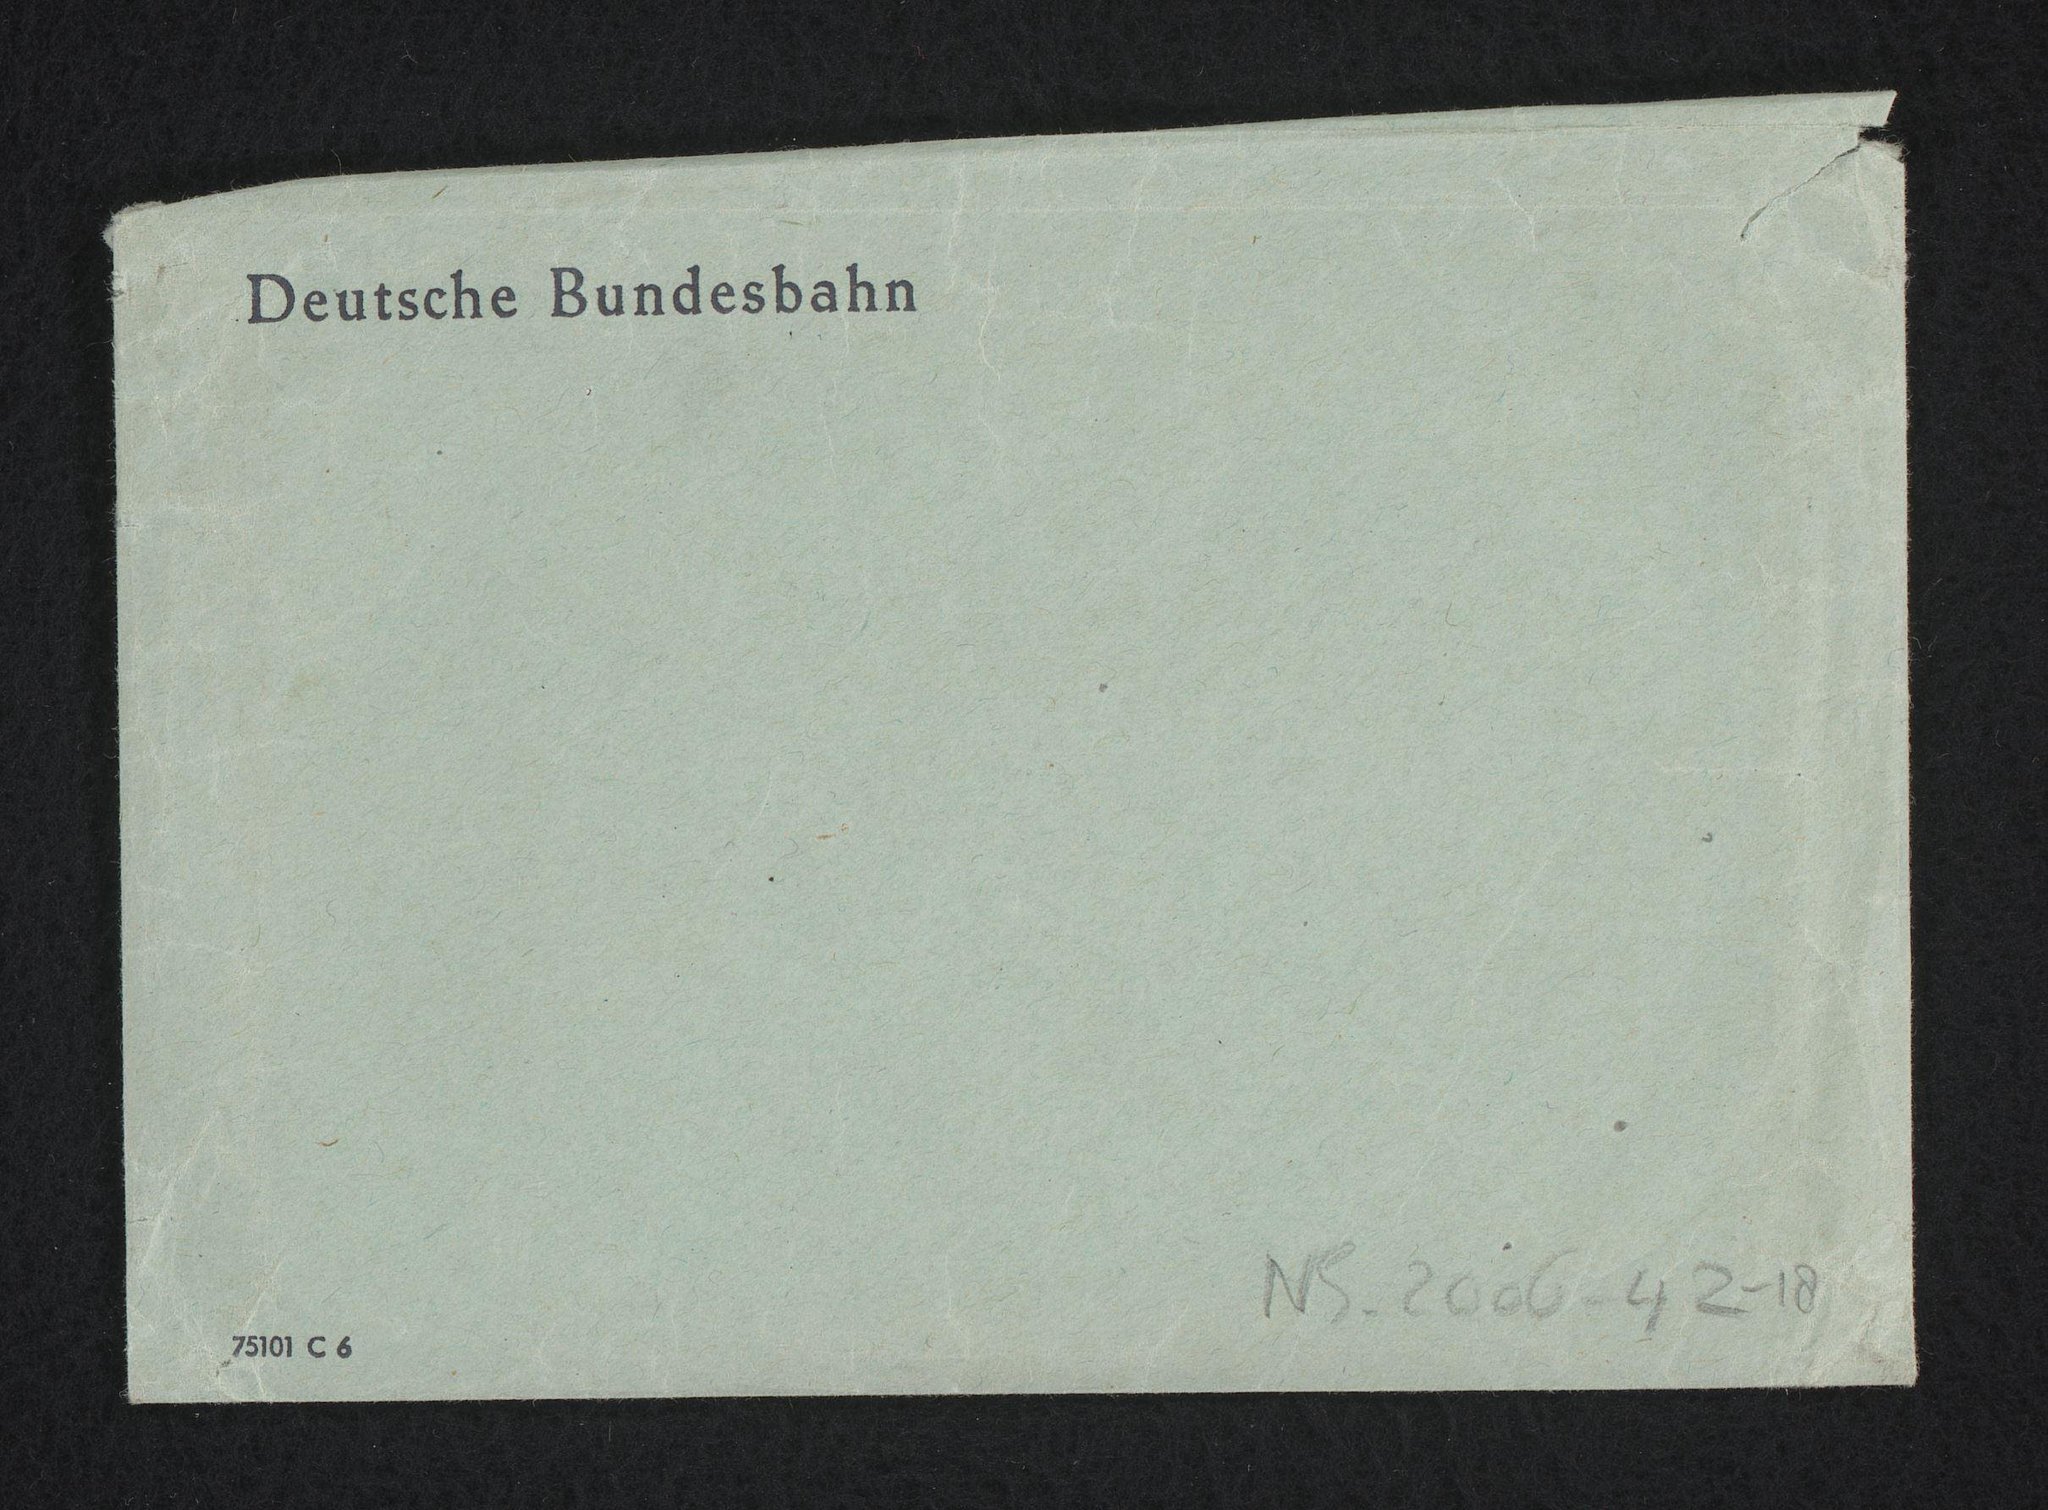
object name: folder container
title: Envelop met losse foto's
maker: Anonymous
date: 1943-1944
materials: cardboard, photographic support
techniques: gelatin silver print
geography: utrecht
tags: sports, etc. on land, outing, pleasure trip, public gardens, park, utrecht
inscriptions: inscription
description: Envelop 'Deutsche Bundesbahn' met negen losse foto's: een portret van de samensteller van het album, enkele dubbele foto's van sportactiviteiten in een park in Utrecht (zie albumblad 14) en twee foto's van militairen. Onderdeel van het fotoalbum Deutsche Reichsbahn, 1943-1944.